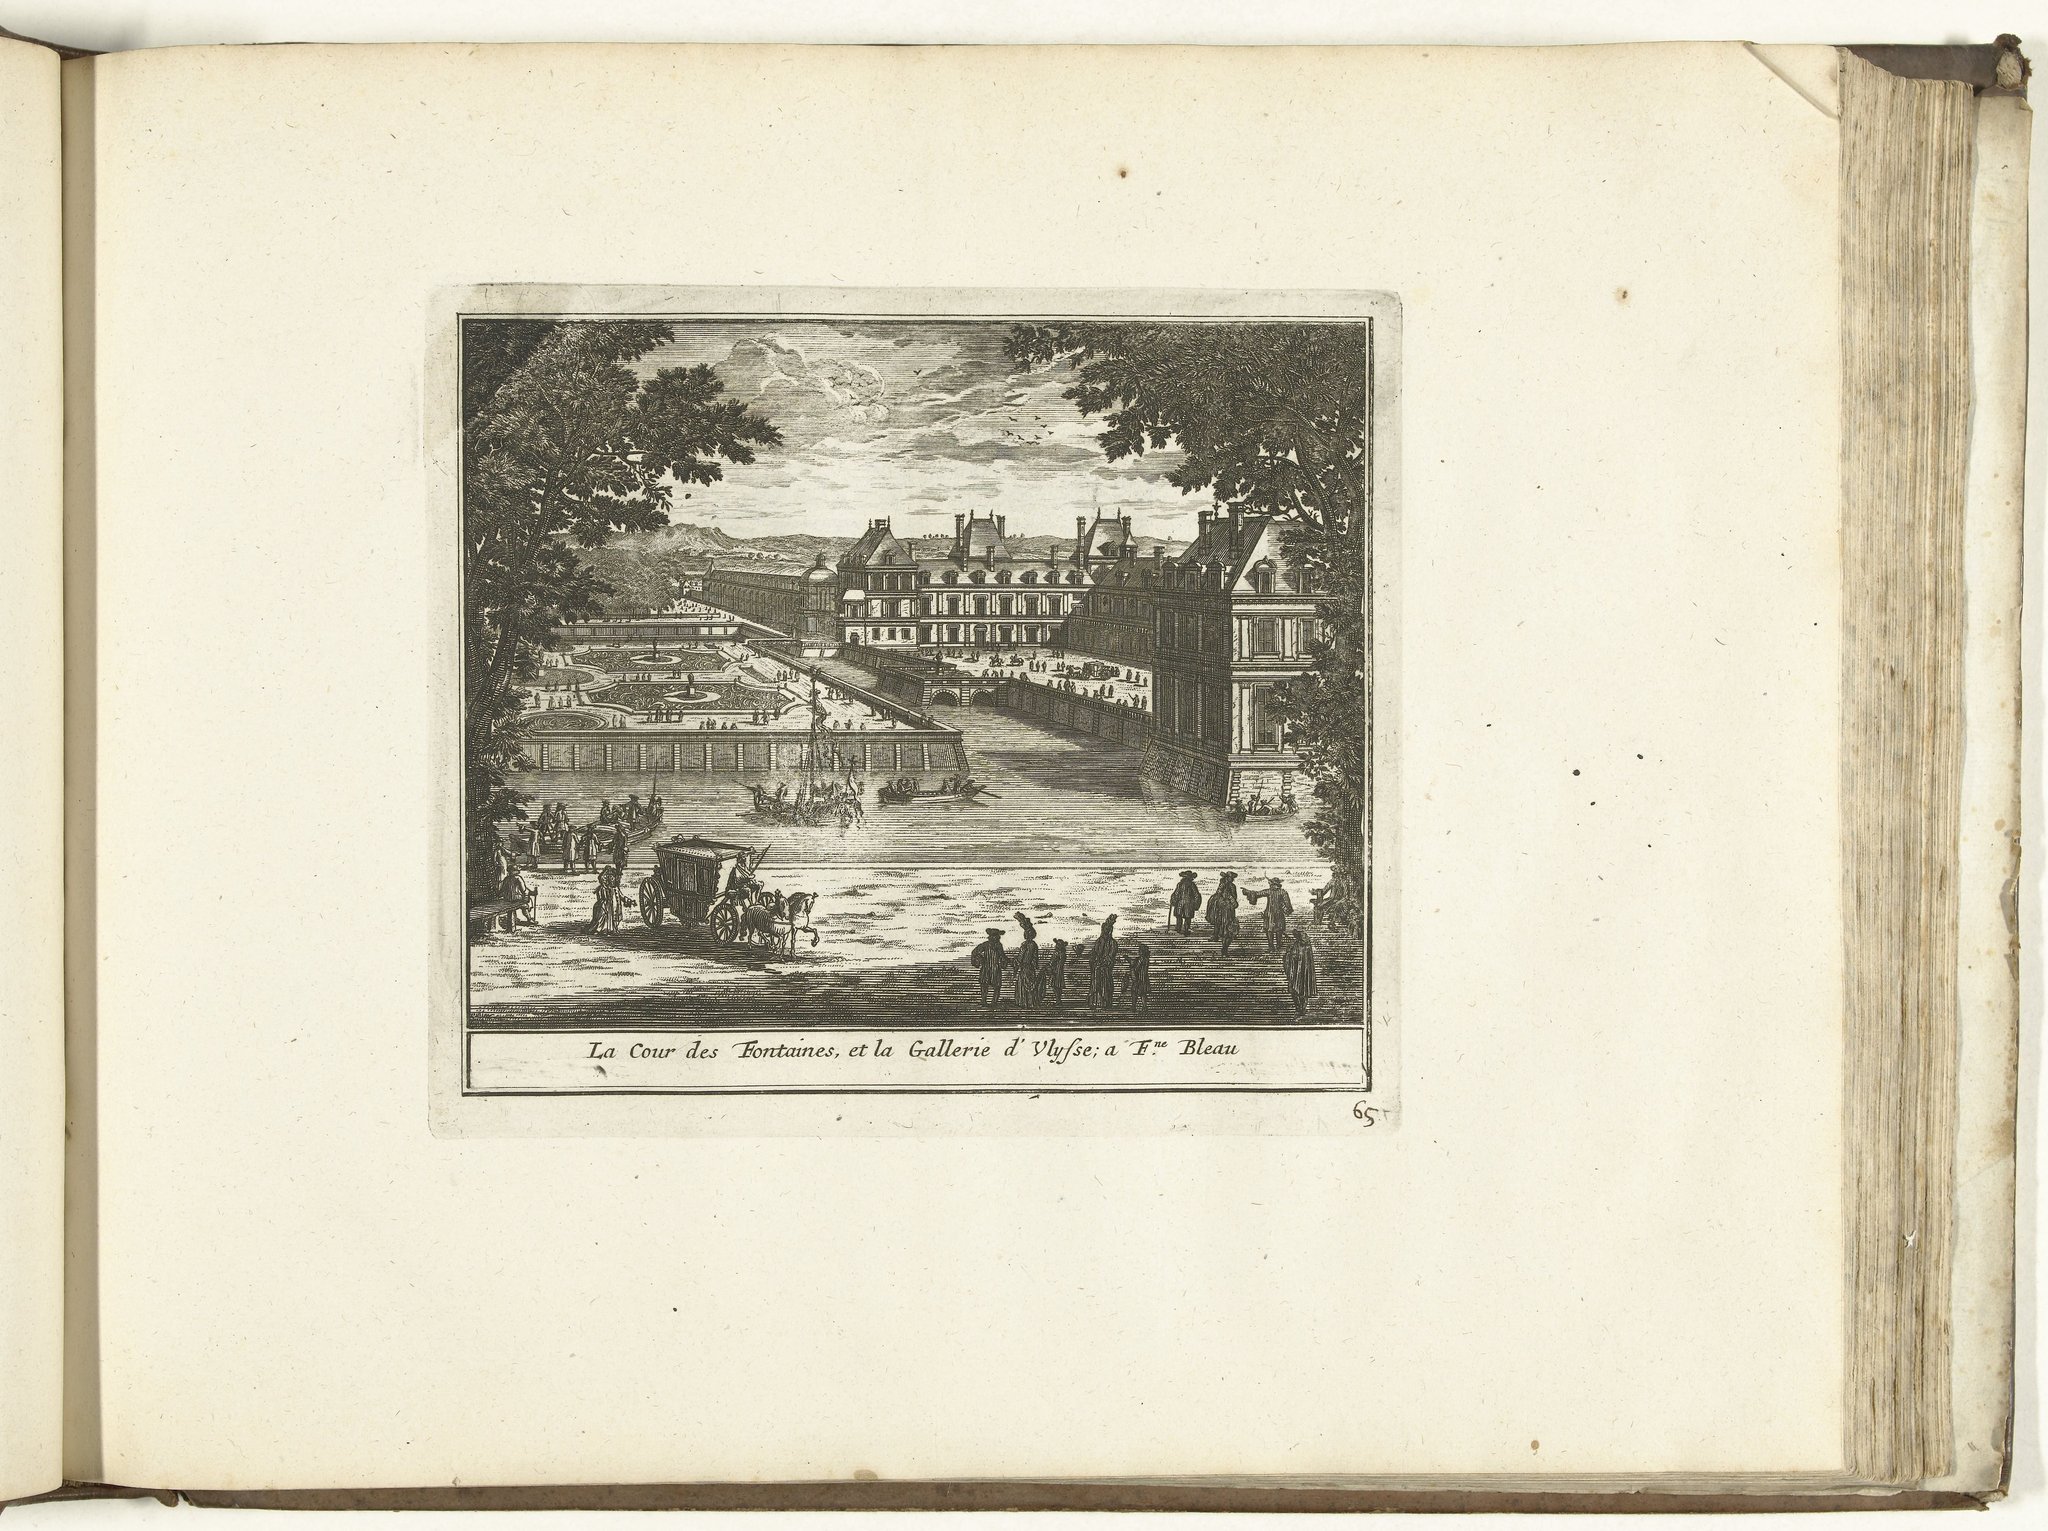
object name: print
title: Gezicht op de Cour de la Fontaine in het paleis van Fontainebleau, 1726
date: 1726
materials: paper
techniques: etching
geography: leiden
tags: palace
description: Gezicht op de Cour de la Fontaine en de galerie d'Ulysse in het paleis van Fontainebleau. Plaat nr. 65 in deel III van het prentwerk: Les Forces de l'Europe, Asie, Afrique et Amerique ... Comme aussi les Cartes des Côtes de France et d'Espagne uit 1726, dit eerste deel met 238 met de hand genummerde platen van vermaarde sterke steden en vestingen in het kader van de Spaanse Successieoorlog 1701-1713. Voor het merendeel zijn deze platen gekopieerd naar de anonieme Franse platen van vermaarde sterke steden en vestingen: in Les forces de l'Europe en in: Le theatre de la guerre, dans les Pays-Bas, beide oorspronkelijk uitgegeven door Nicolas de Fer te Parijs (1693-1697) in het kader van de Negenjarige Oorlog. Titel in het Frans.